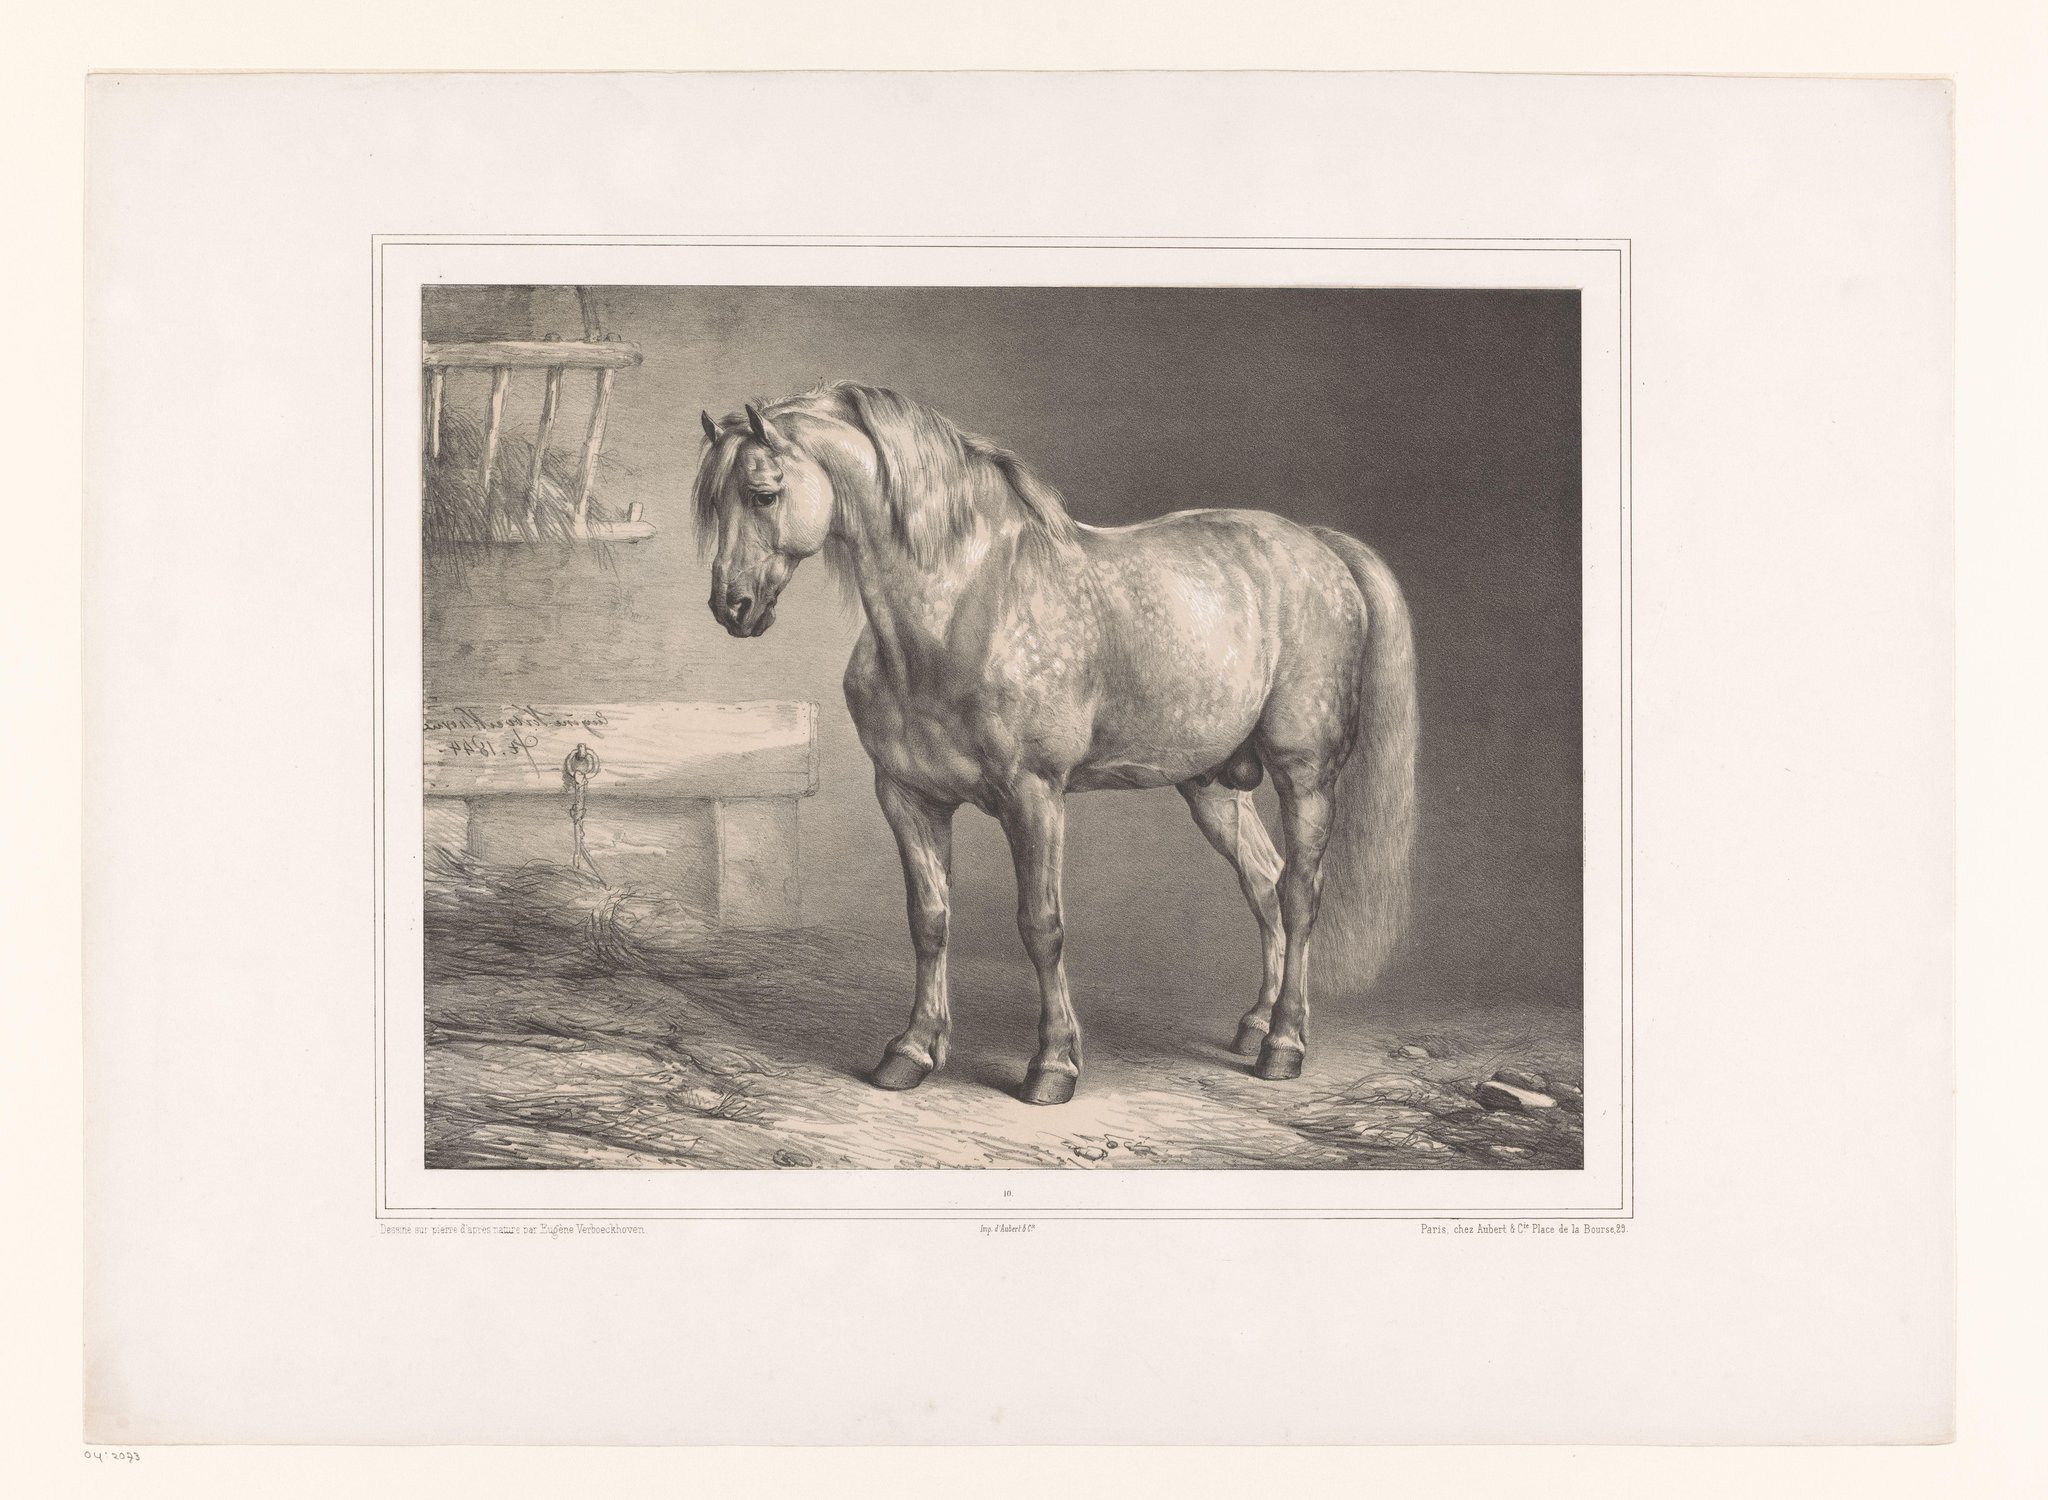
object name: print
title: Paard in een stal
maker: eugène verboeckhoven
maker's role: draughtsman, painter, print maker, printer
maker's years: 1798-1881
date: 1844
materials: paper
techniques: tone lithography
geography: paris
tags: horse, stall, stable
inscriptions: collector's mark: Lugt 2228